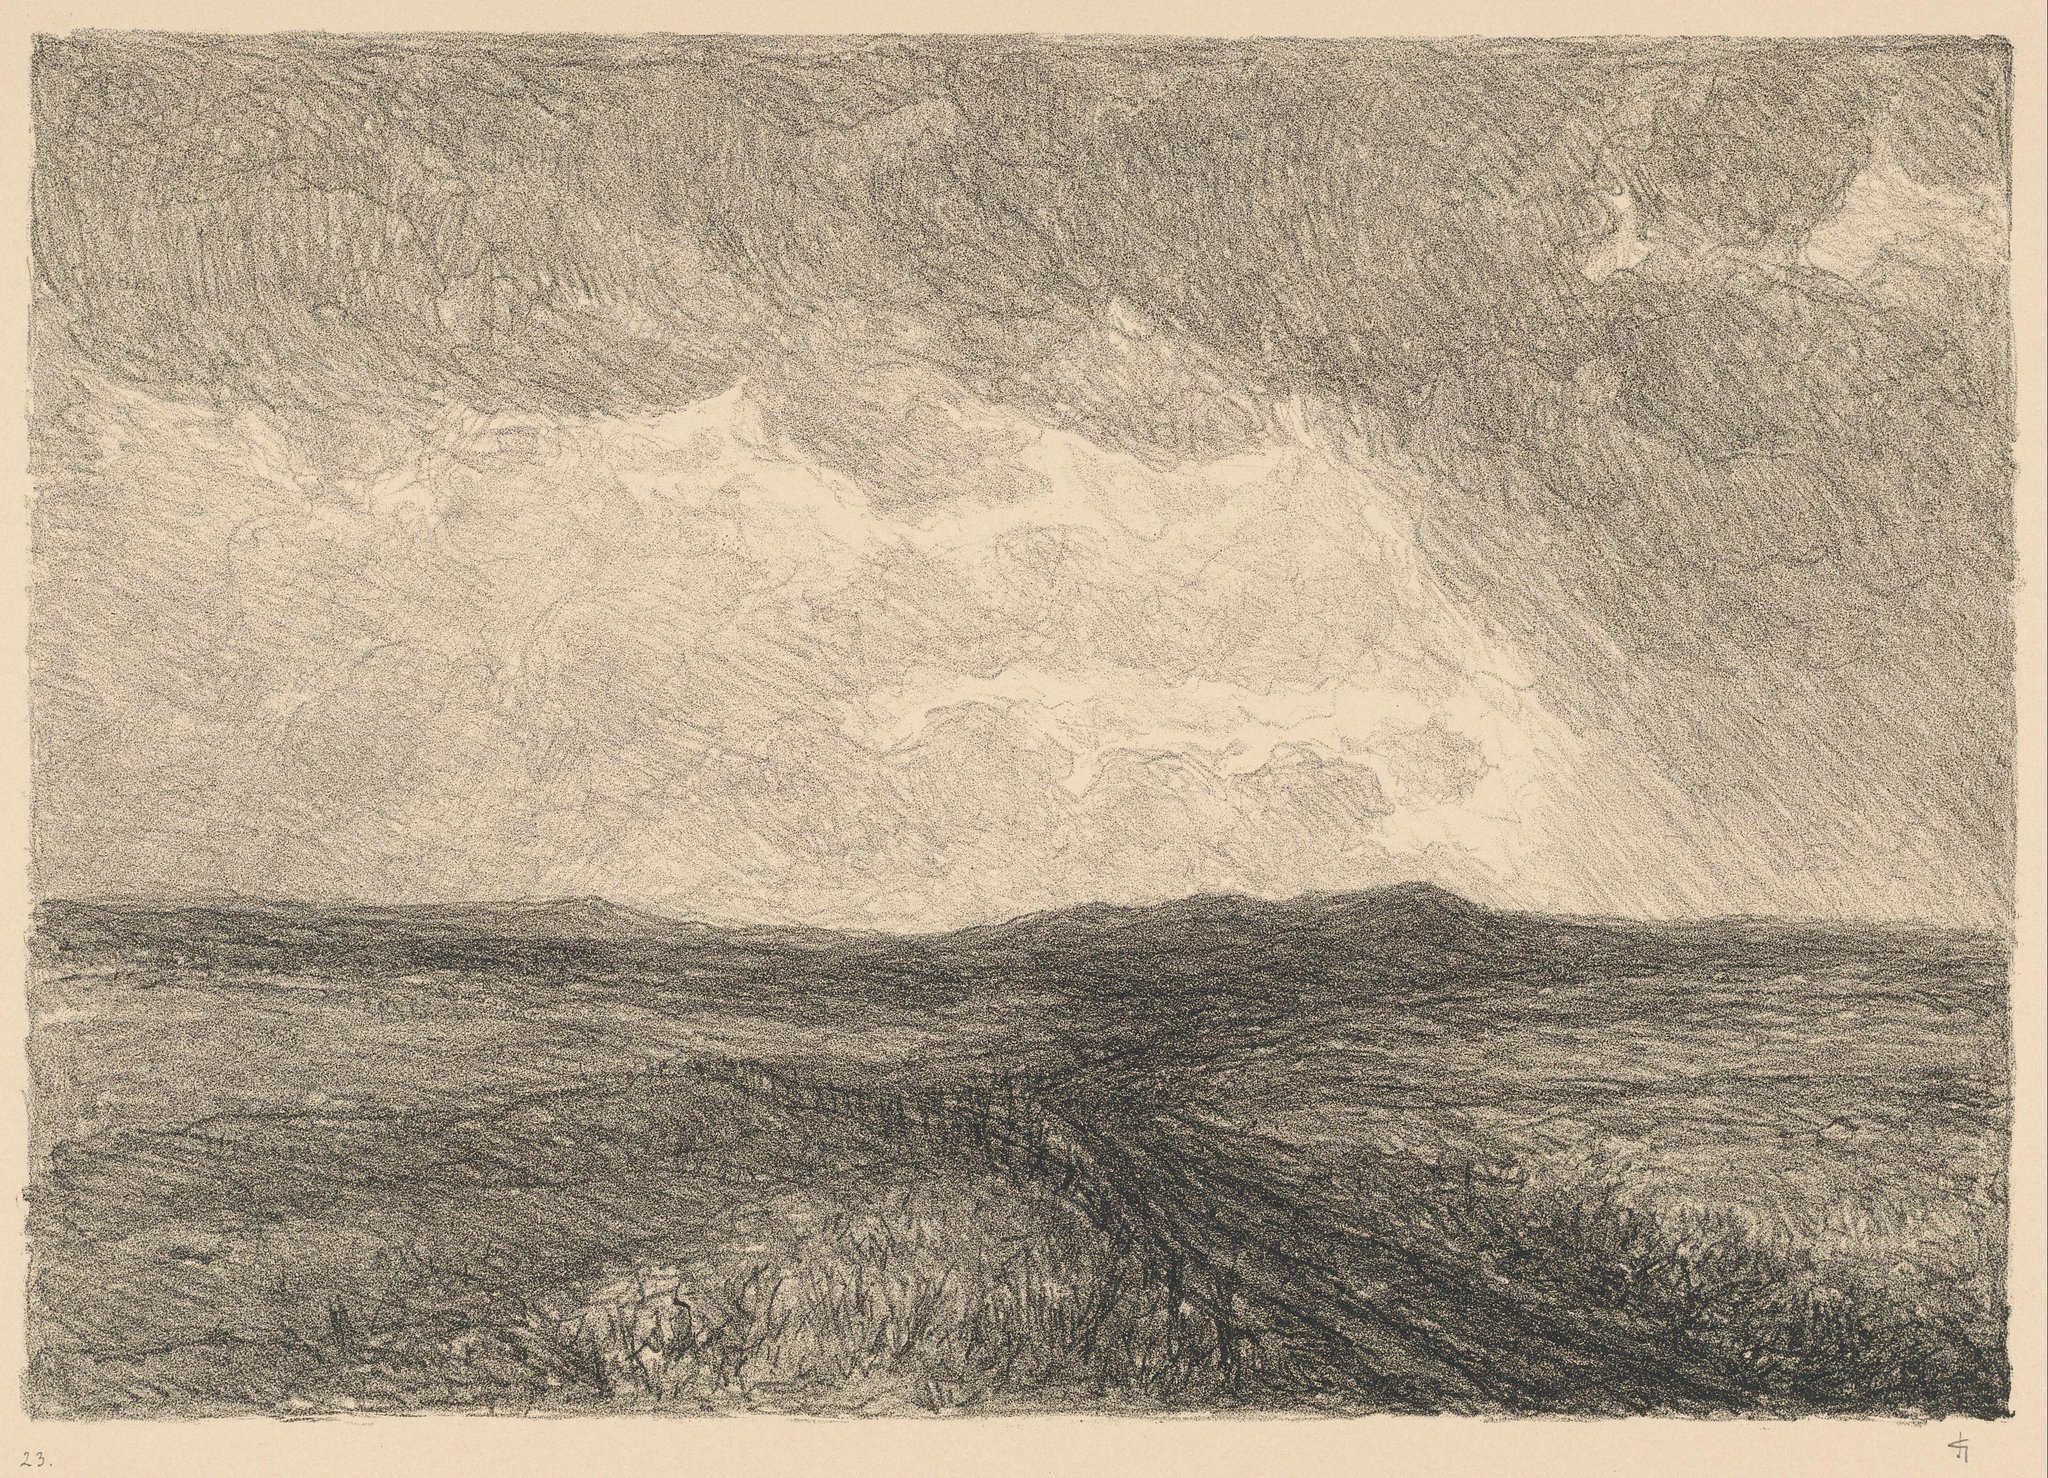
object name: print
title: Duinen bij Katwijk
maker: carel nicolaas storm van s-gravesande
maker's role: draughtsman, print maker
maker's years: 1841-1924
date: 1851-1902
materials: paper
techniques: lithograph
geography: netherlands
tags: dunes (sea not visible); in the dunes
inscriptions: collector's mark: Lugt 2228